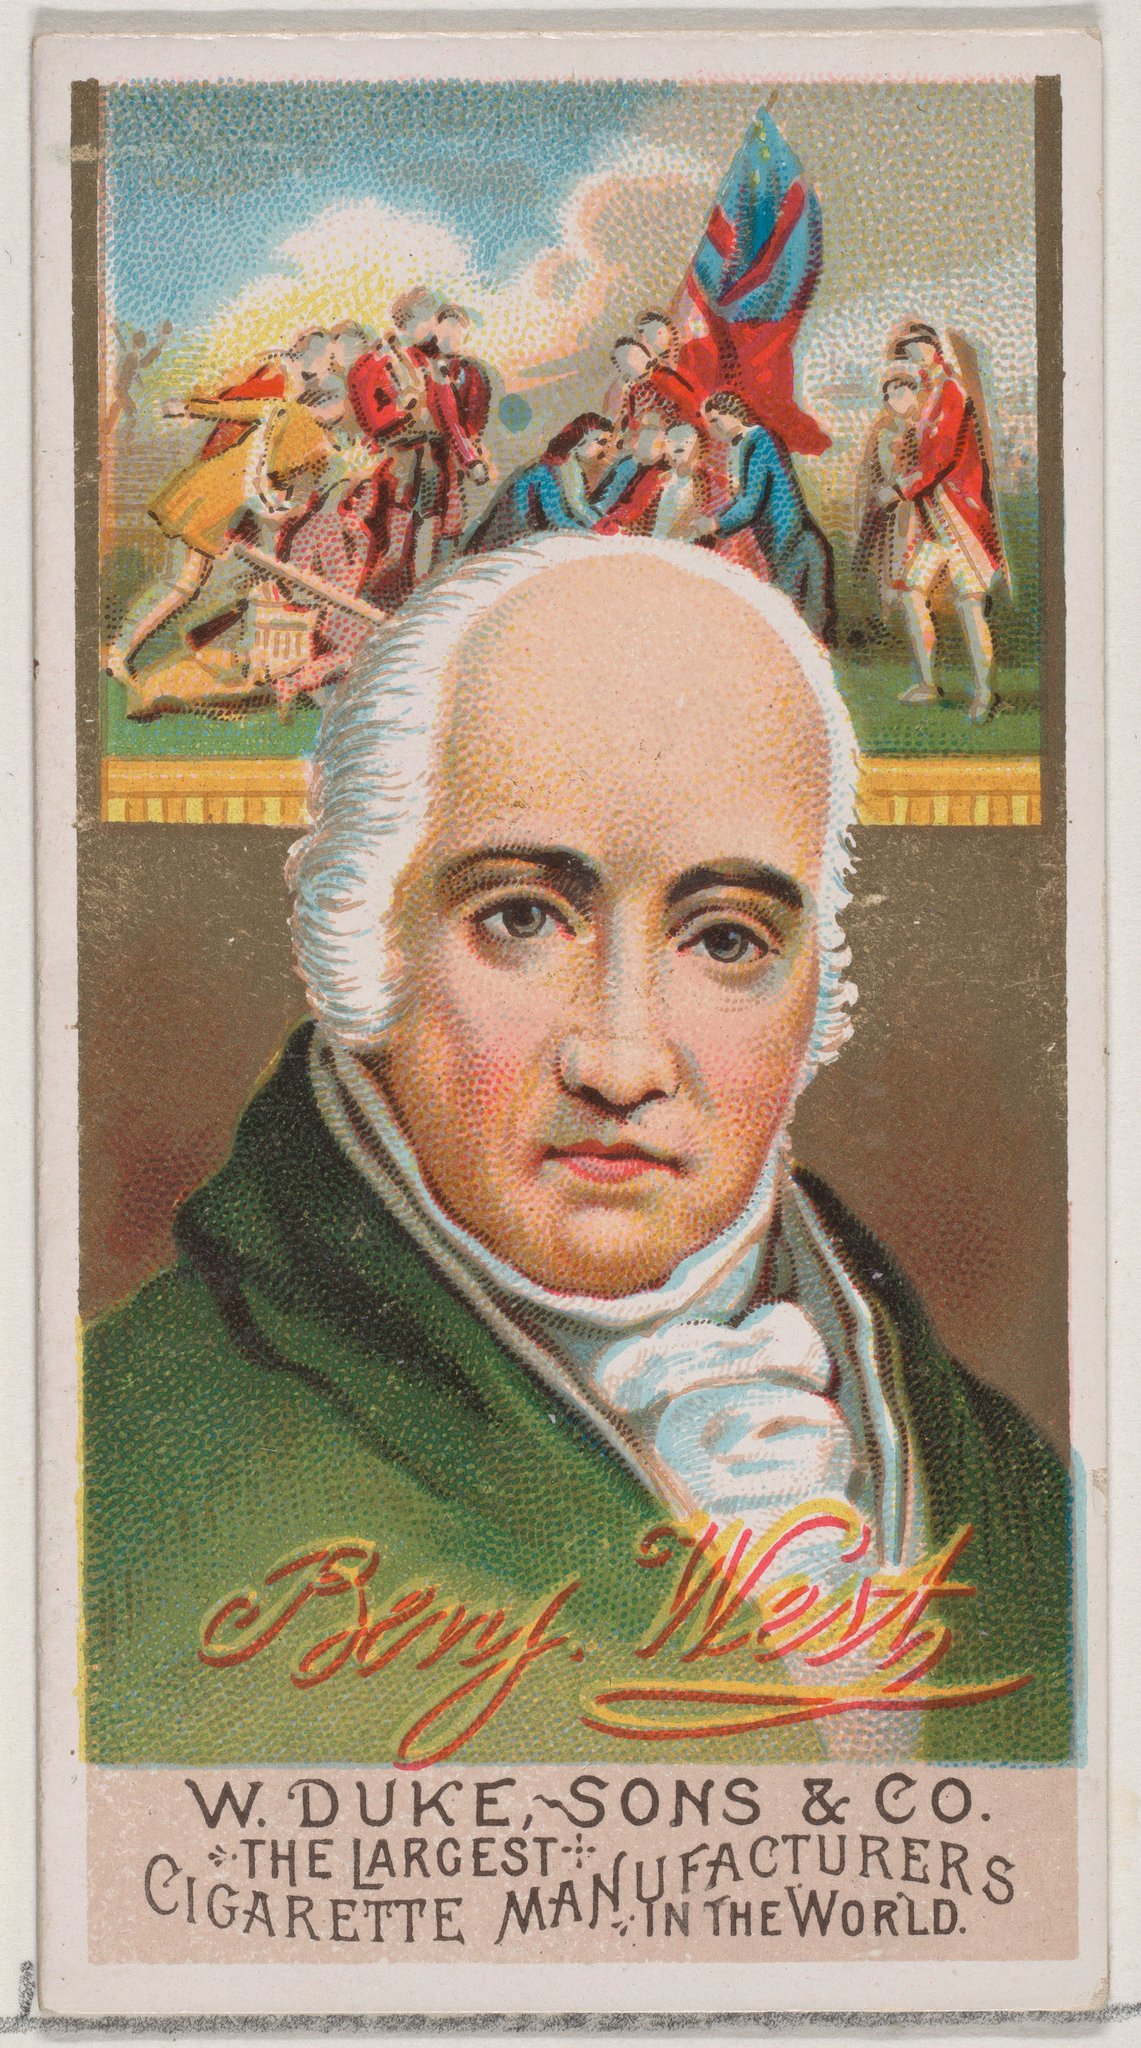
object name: print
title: Benjamin West, from the series Great Americans (N76) for Duke brand cigarettes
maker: w. duke, sons & co.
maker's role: publisher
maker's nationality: american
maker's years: 1870-1920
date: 1888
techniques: color lithograph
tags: men